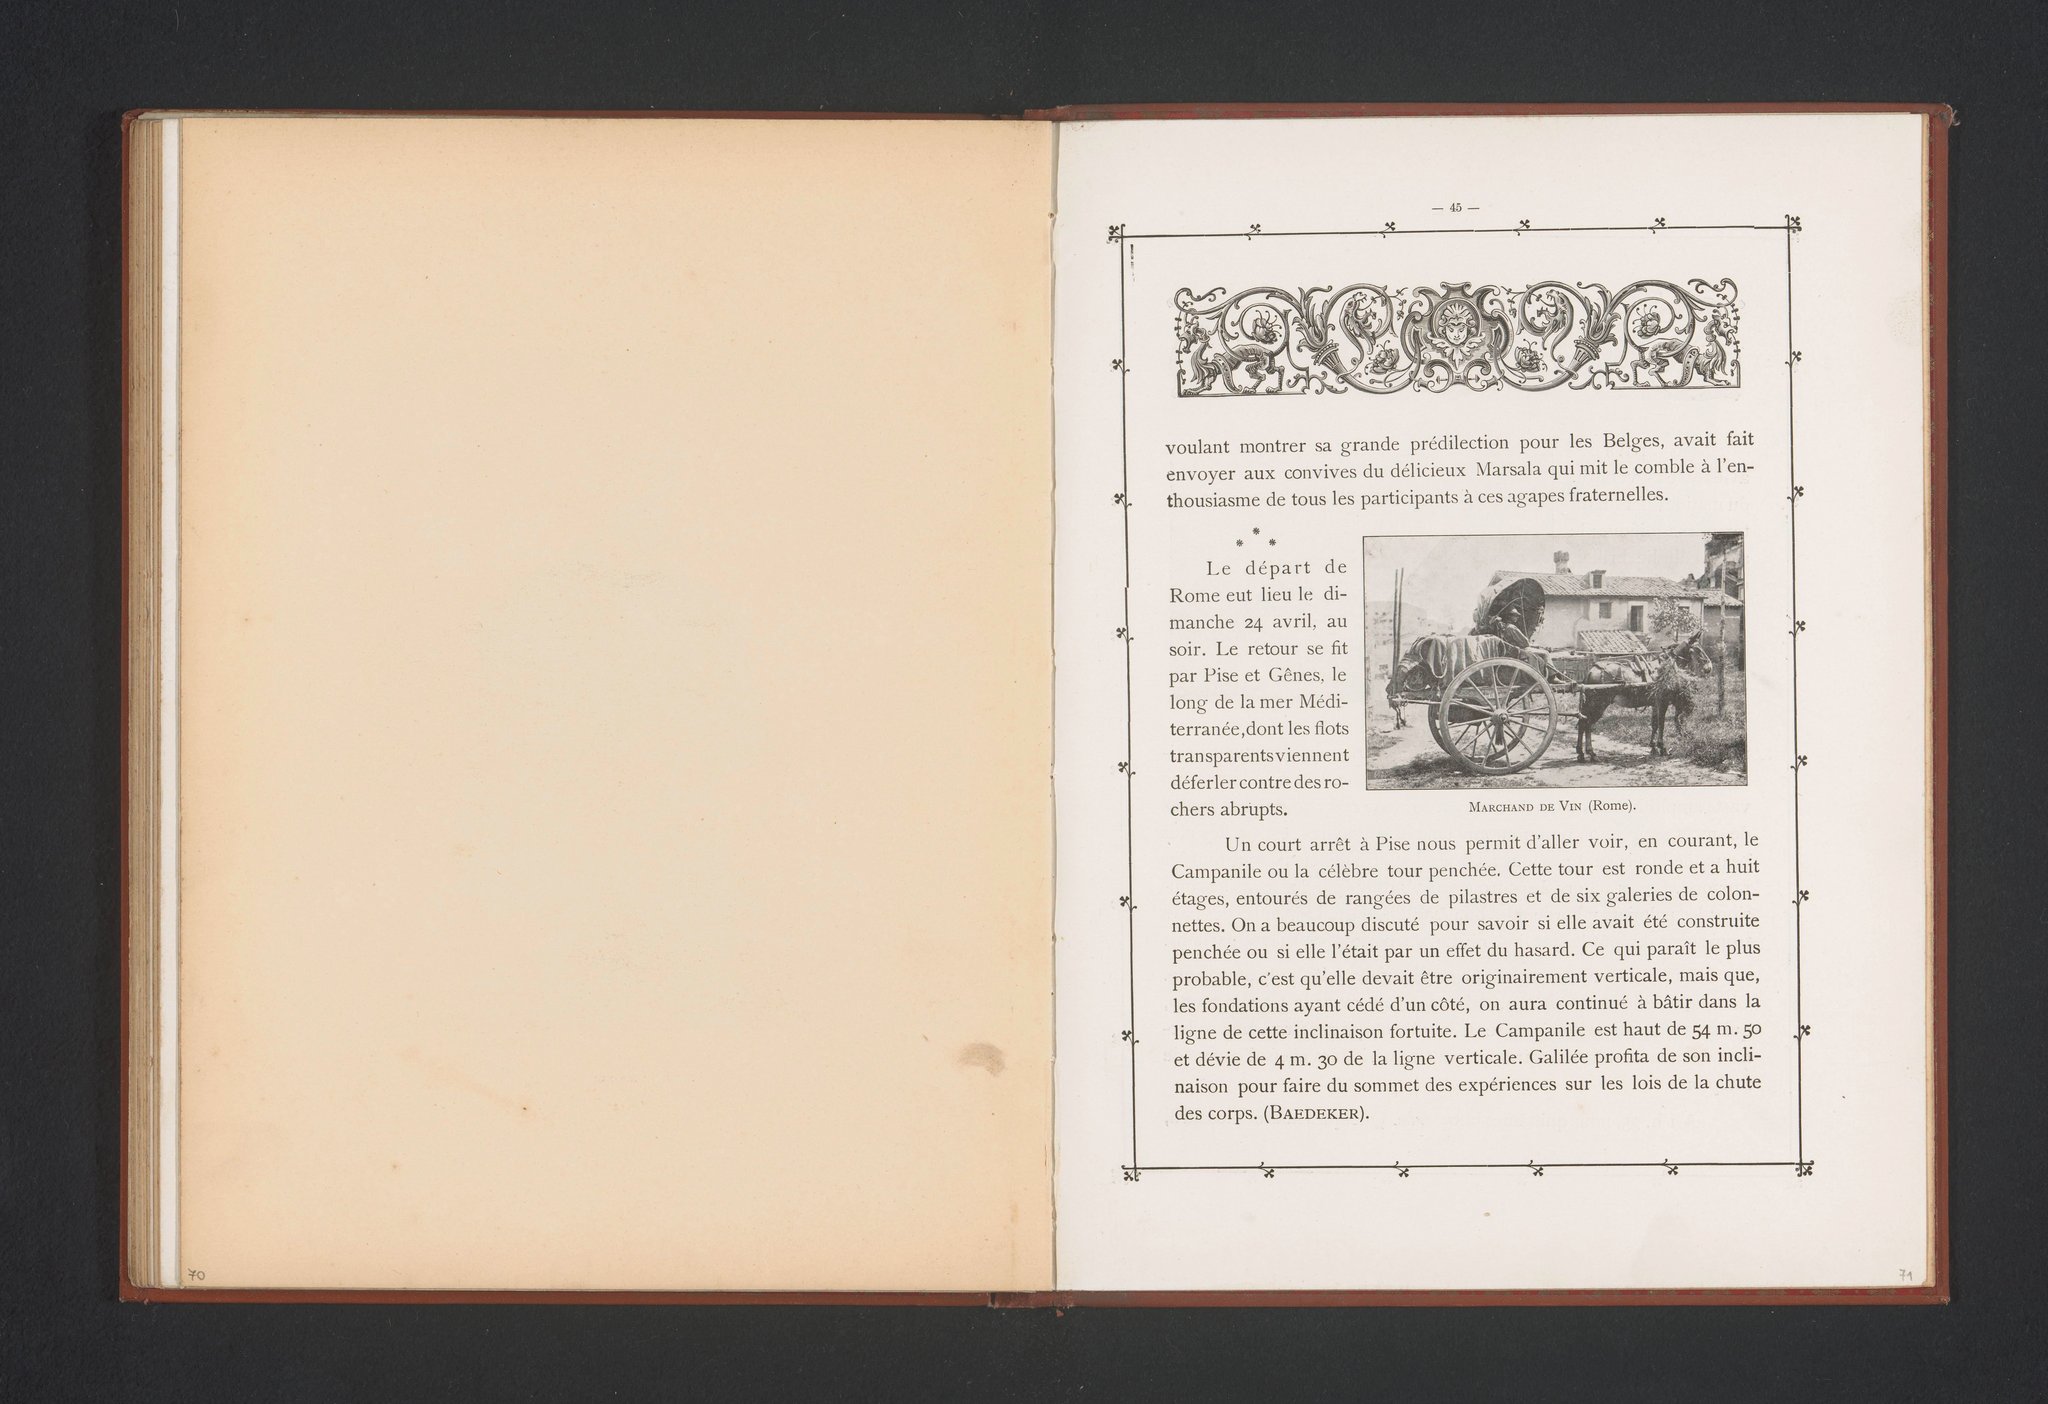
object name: photomechanical print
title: Marchand de Vin (Rome)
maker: Anonymous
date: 1893-1898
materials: paper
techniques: autotype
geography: rome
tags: merchant, salesman (with name of trade or profession), rome